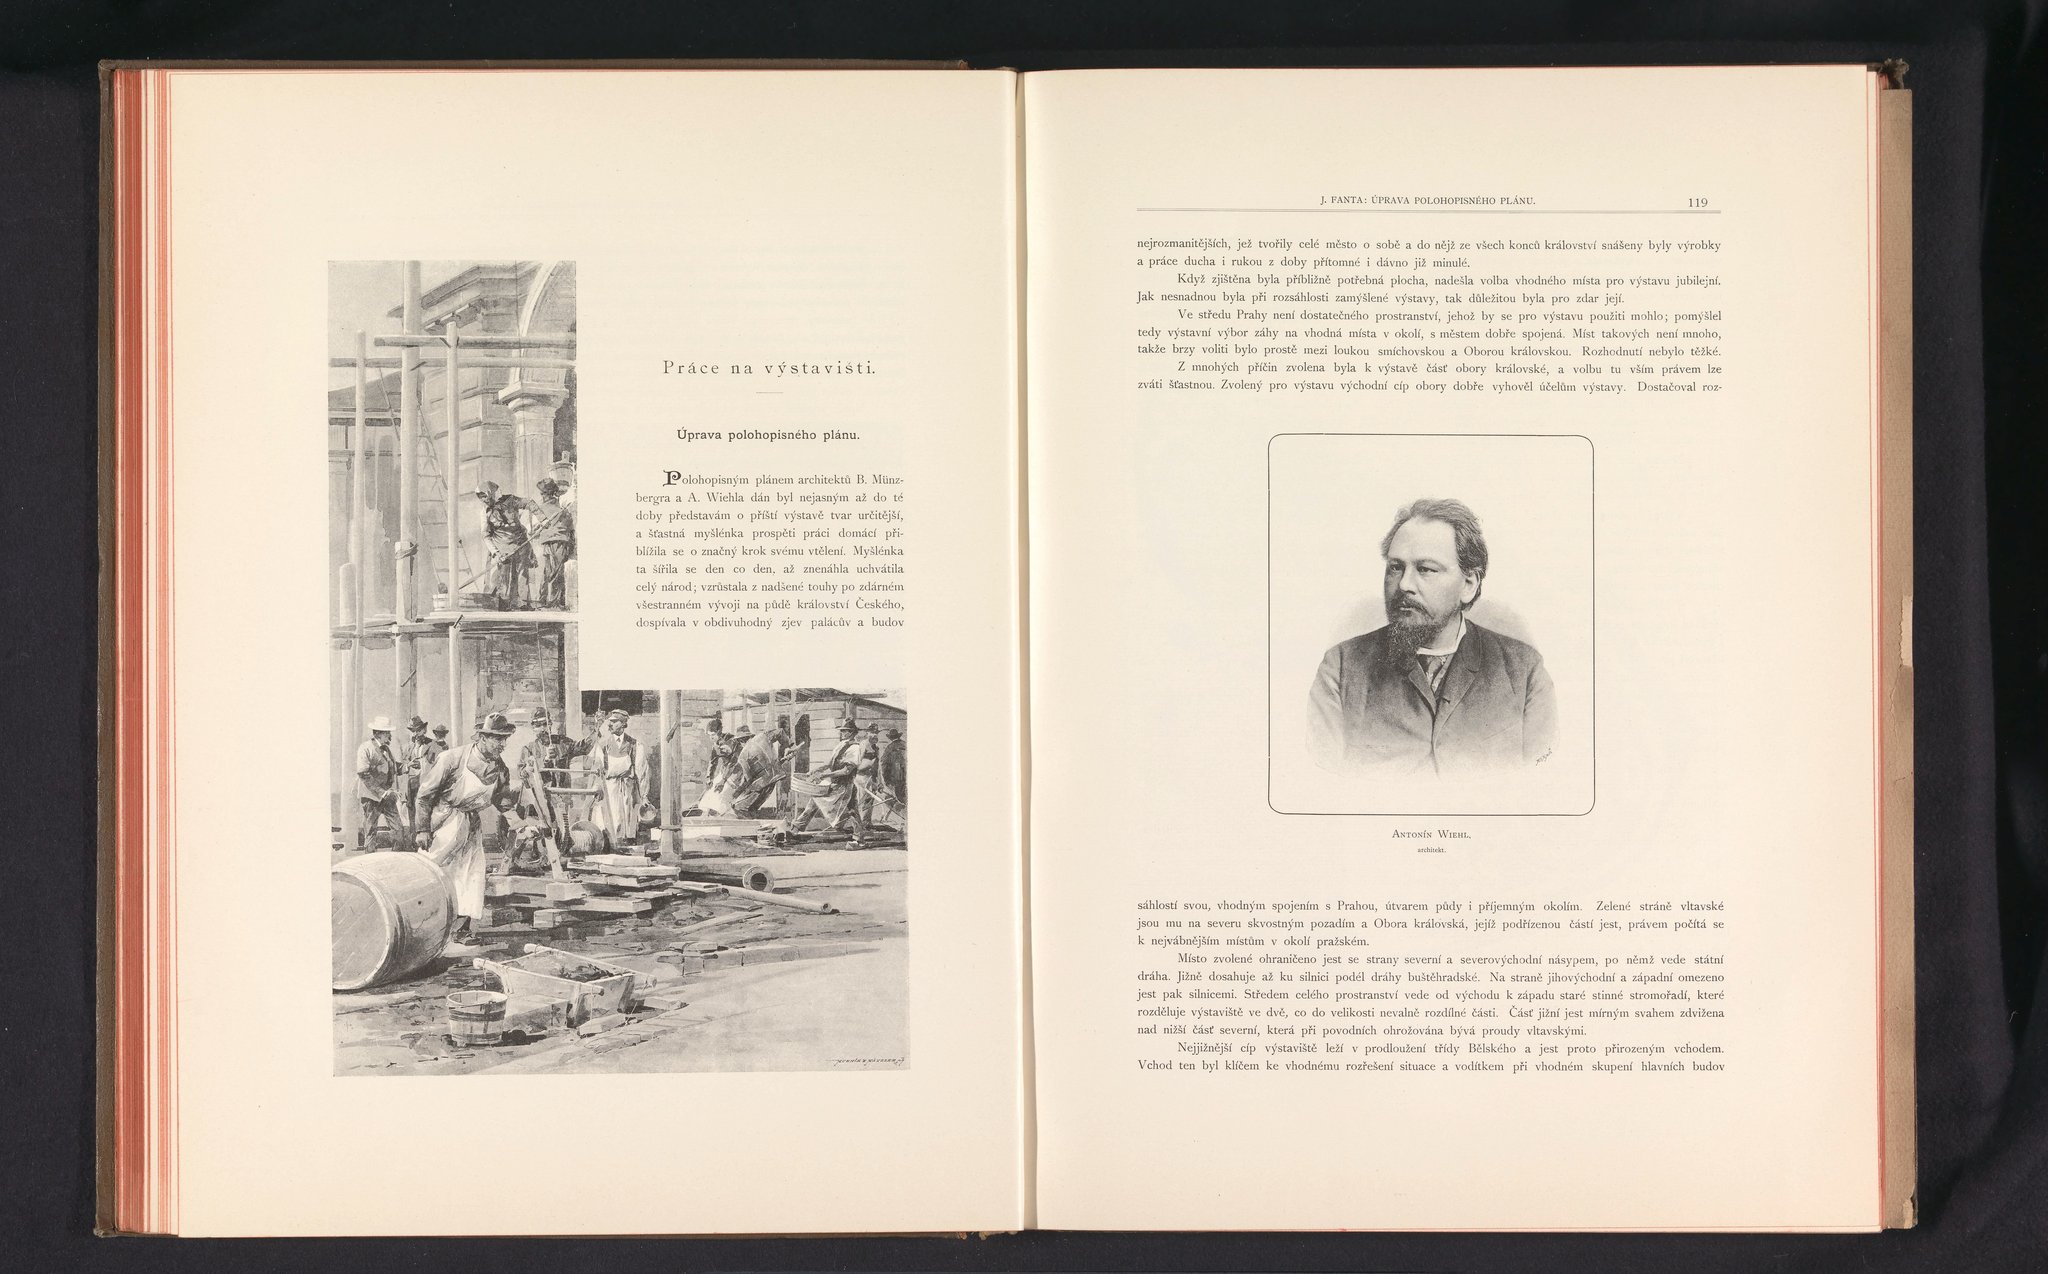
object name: page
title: Antonín Wiehl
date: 1888-1893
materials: paper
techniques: autotype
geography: prague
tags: portrait, self-portrait of architect